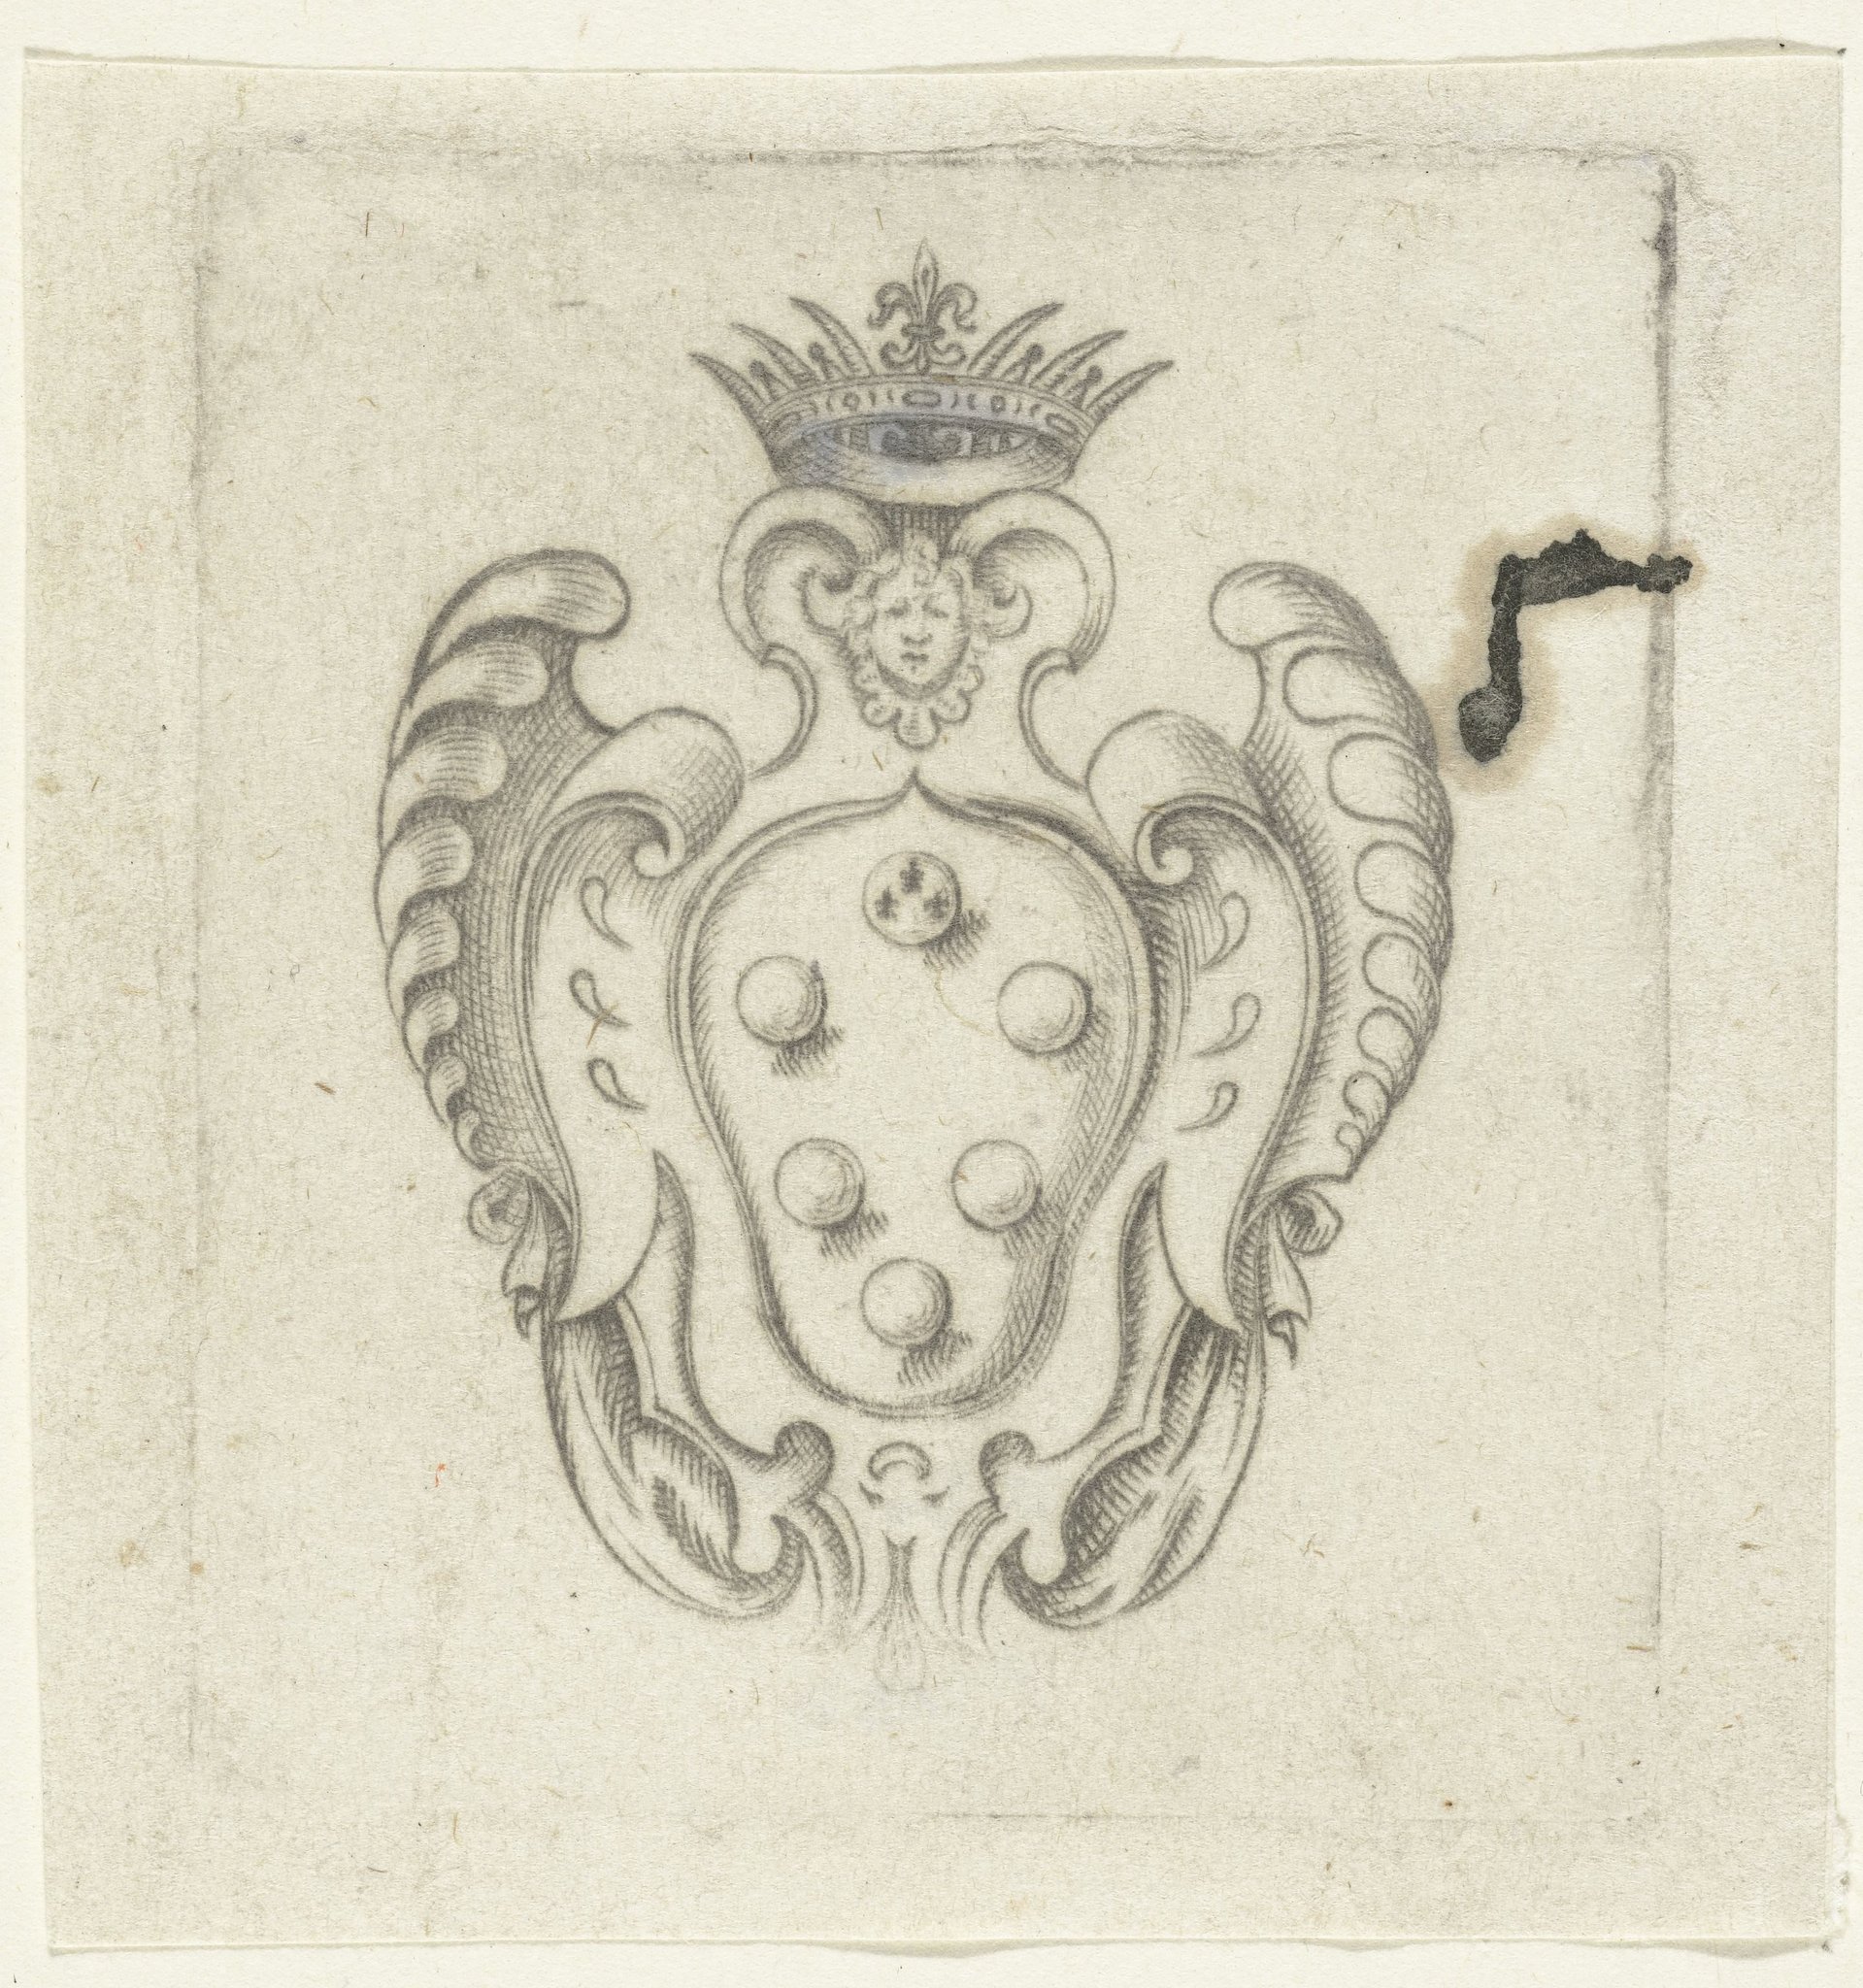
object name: print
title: Wapen van de familie De' Medici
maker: jacques callot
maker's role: draughtsman, print maker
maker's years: 1592-1635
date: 1614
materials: paper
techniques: engraving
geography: florence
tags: crown (symbol of sovereignty), mask, mascaron ~ ornament, armorial bearing, heraldry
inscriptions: collector's mark: Lugt 2233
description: Gebruikt als illustratie (van frontispice) in: Vieri Cerchi, 'Delle lodi di Don Francesco Medici de' principi de Toscana' (Florence: Cosimo Giunti, 1614). Klinkert, C.